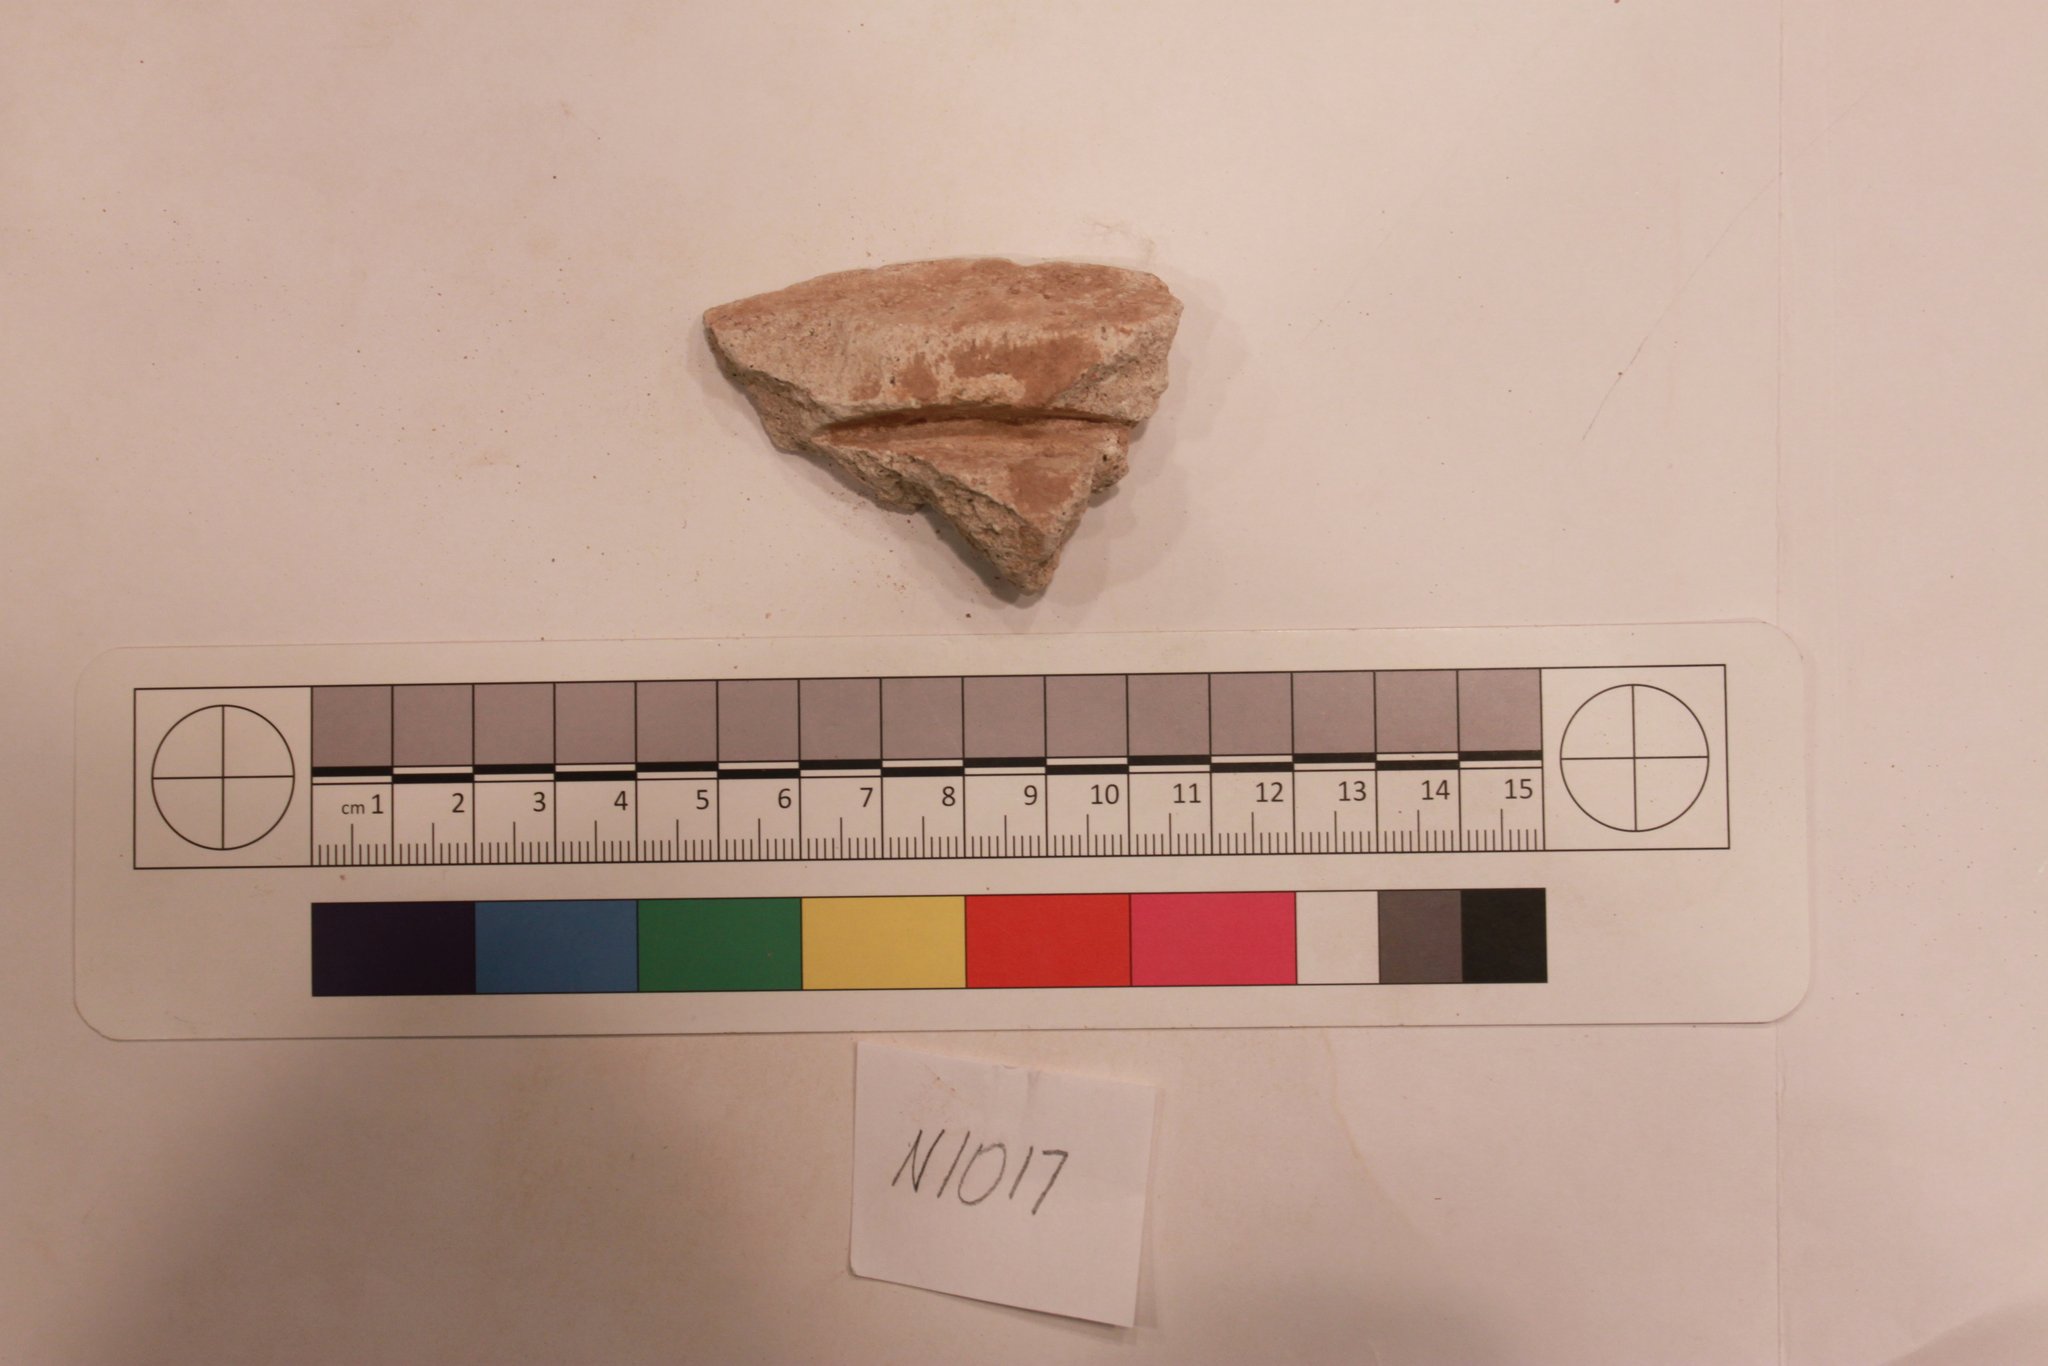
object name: fragment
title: Stucco Fragment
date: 701-1200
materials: plaster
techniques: carving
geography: iran